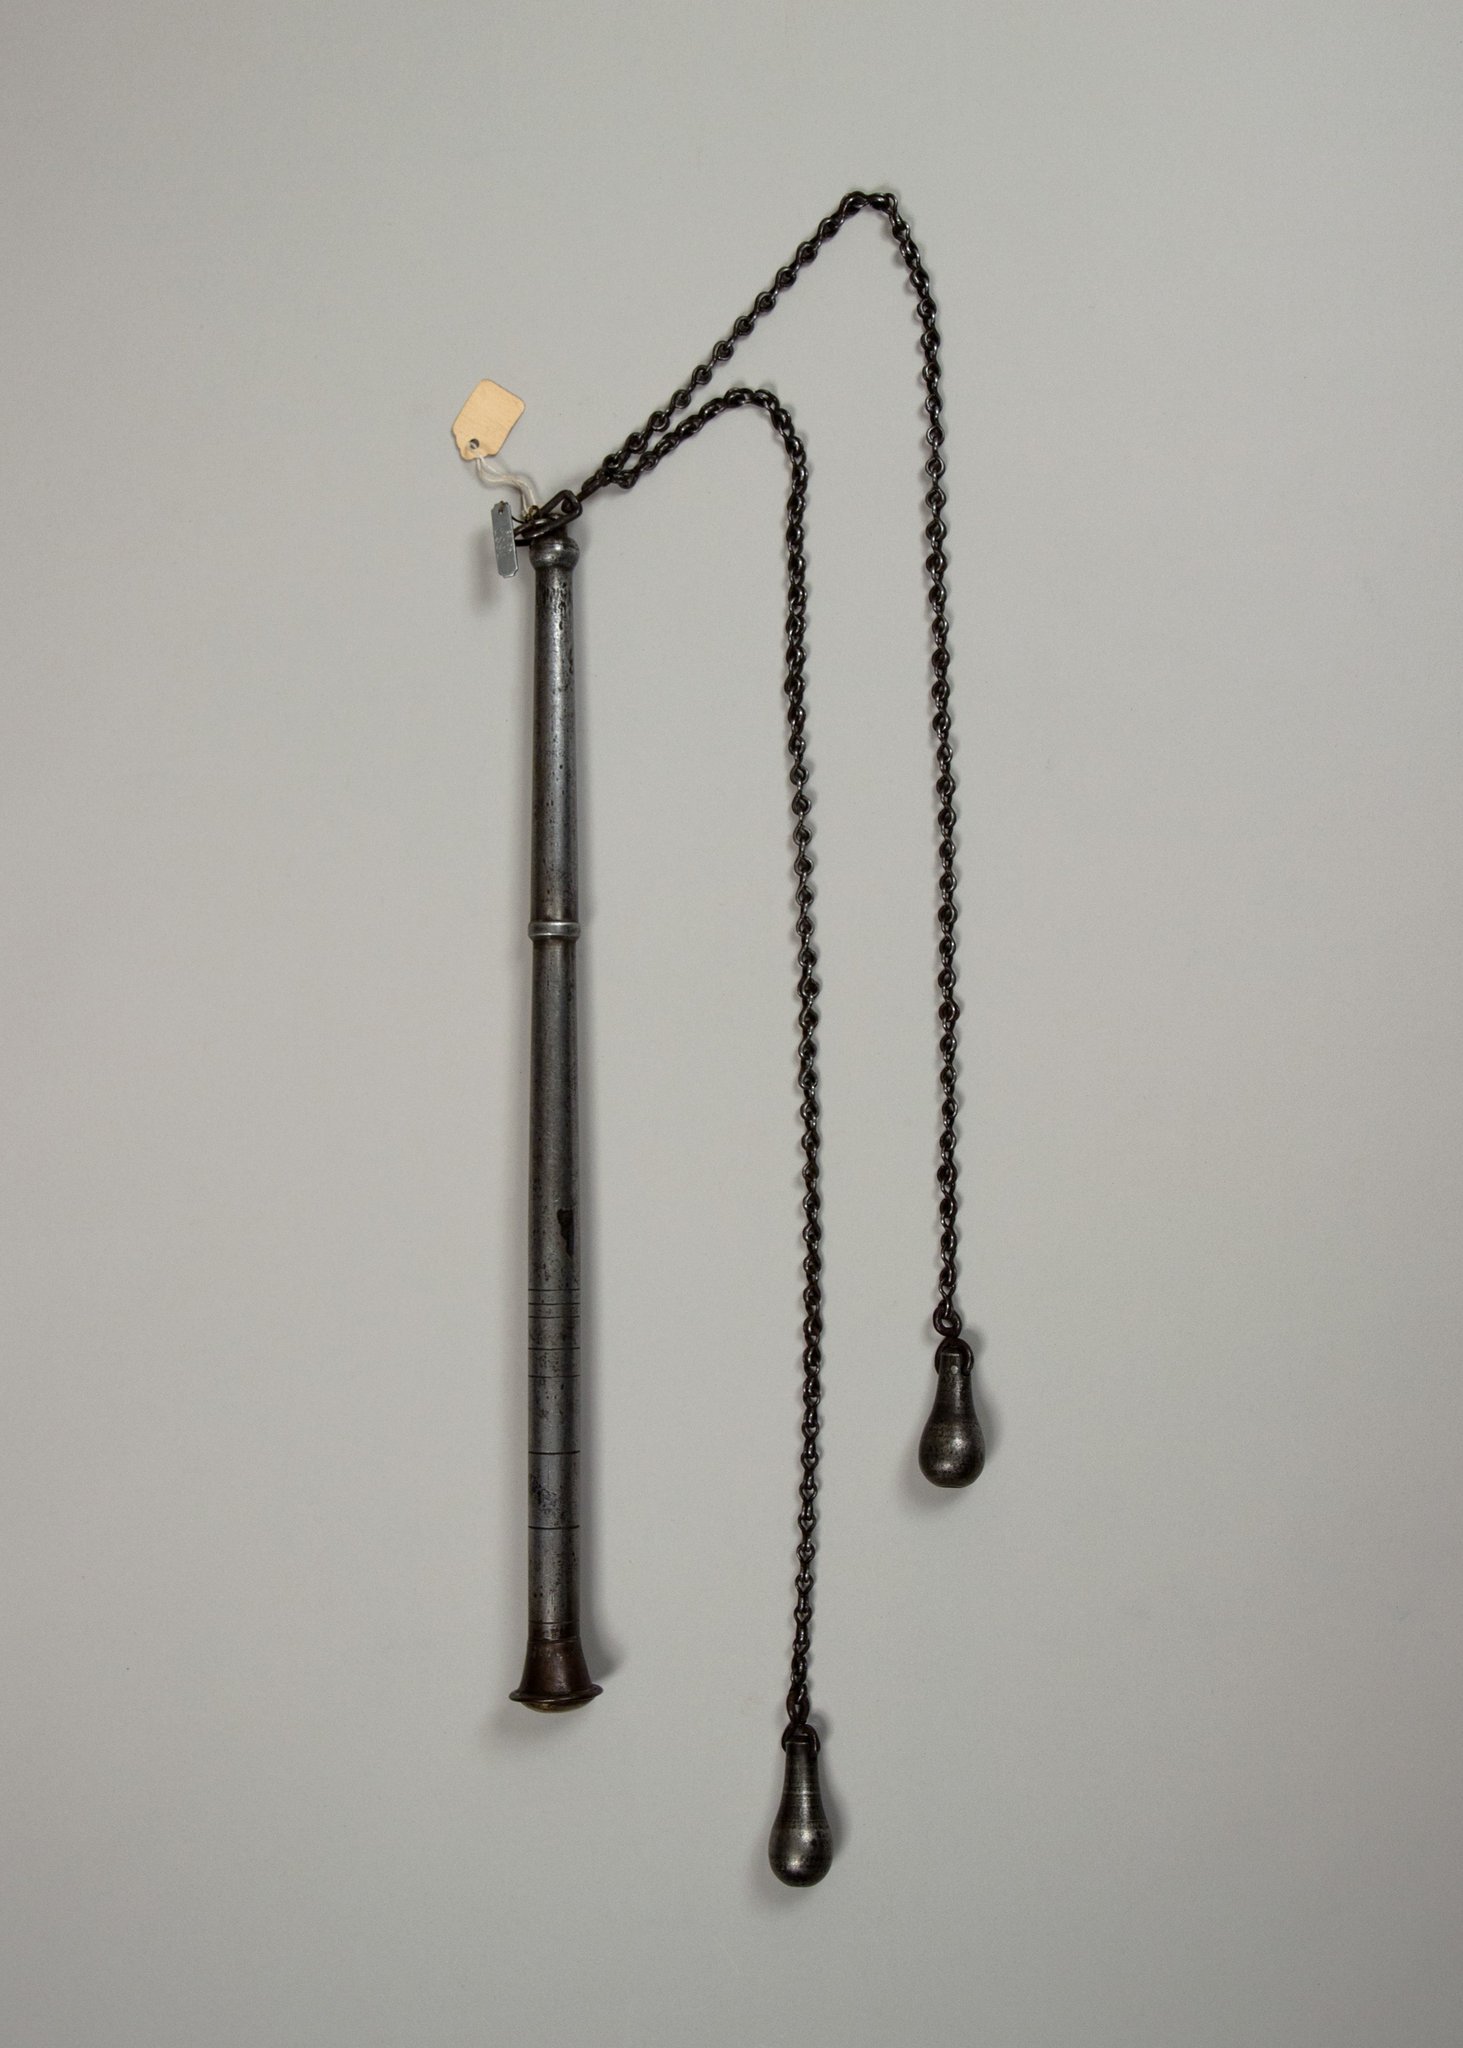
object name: flail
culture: indian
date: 1701-1800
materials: brass, iron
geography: india